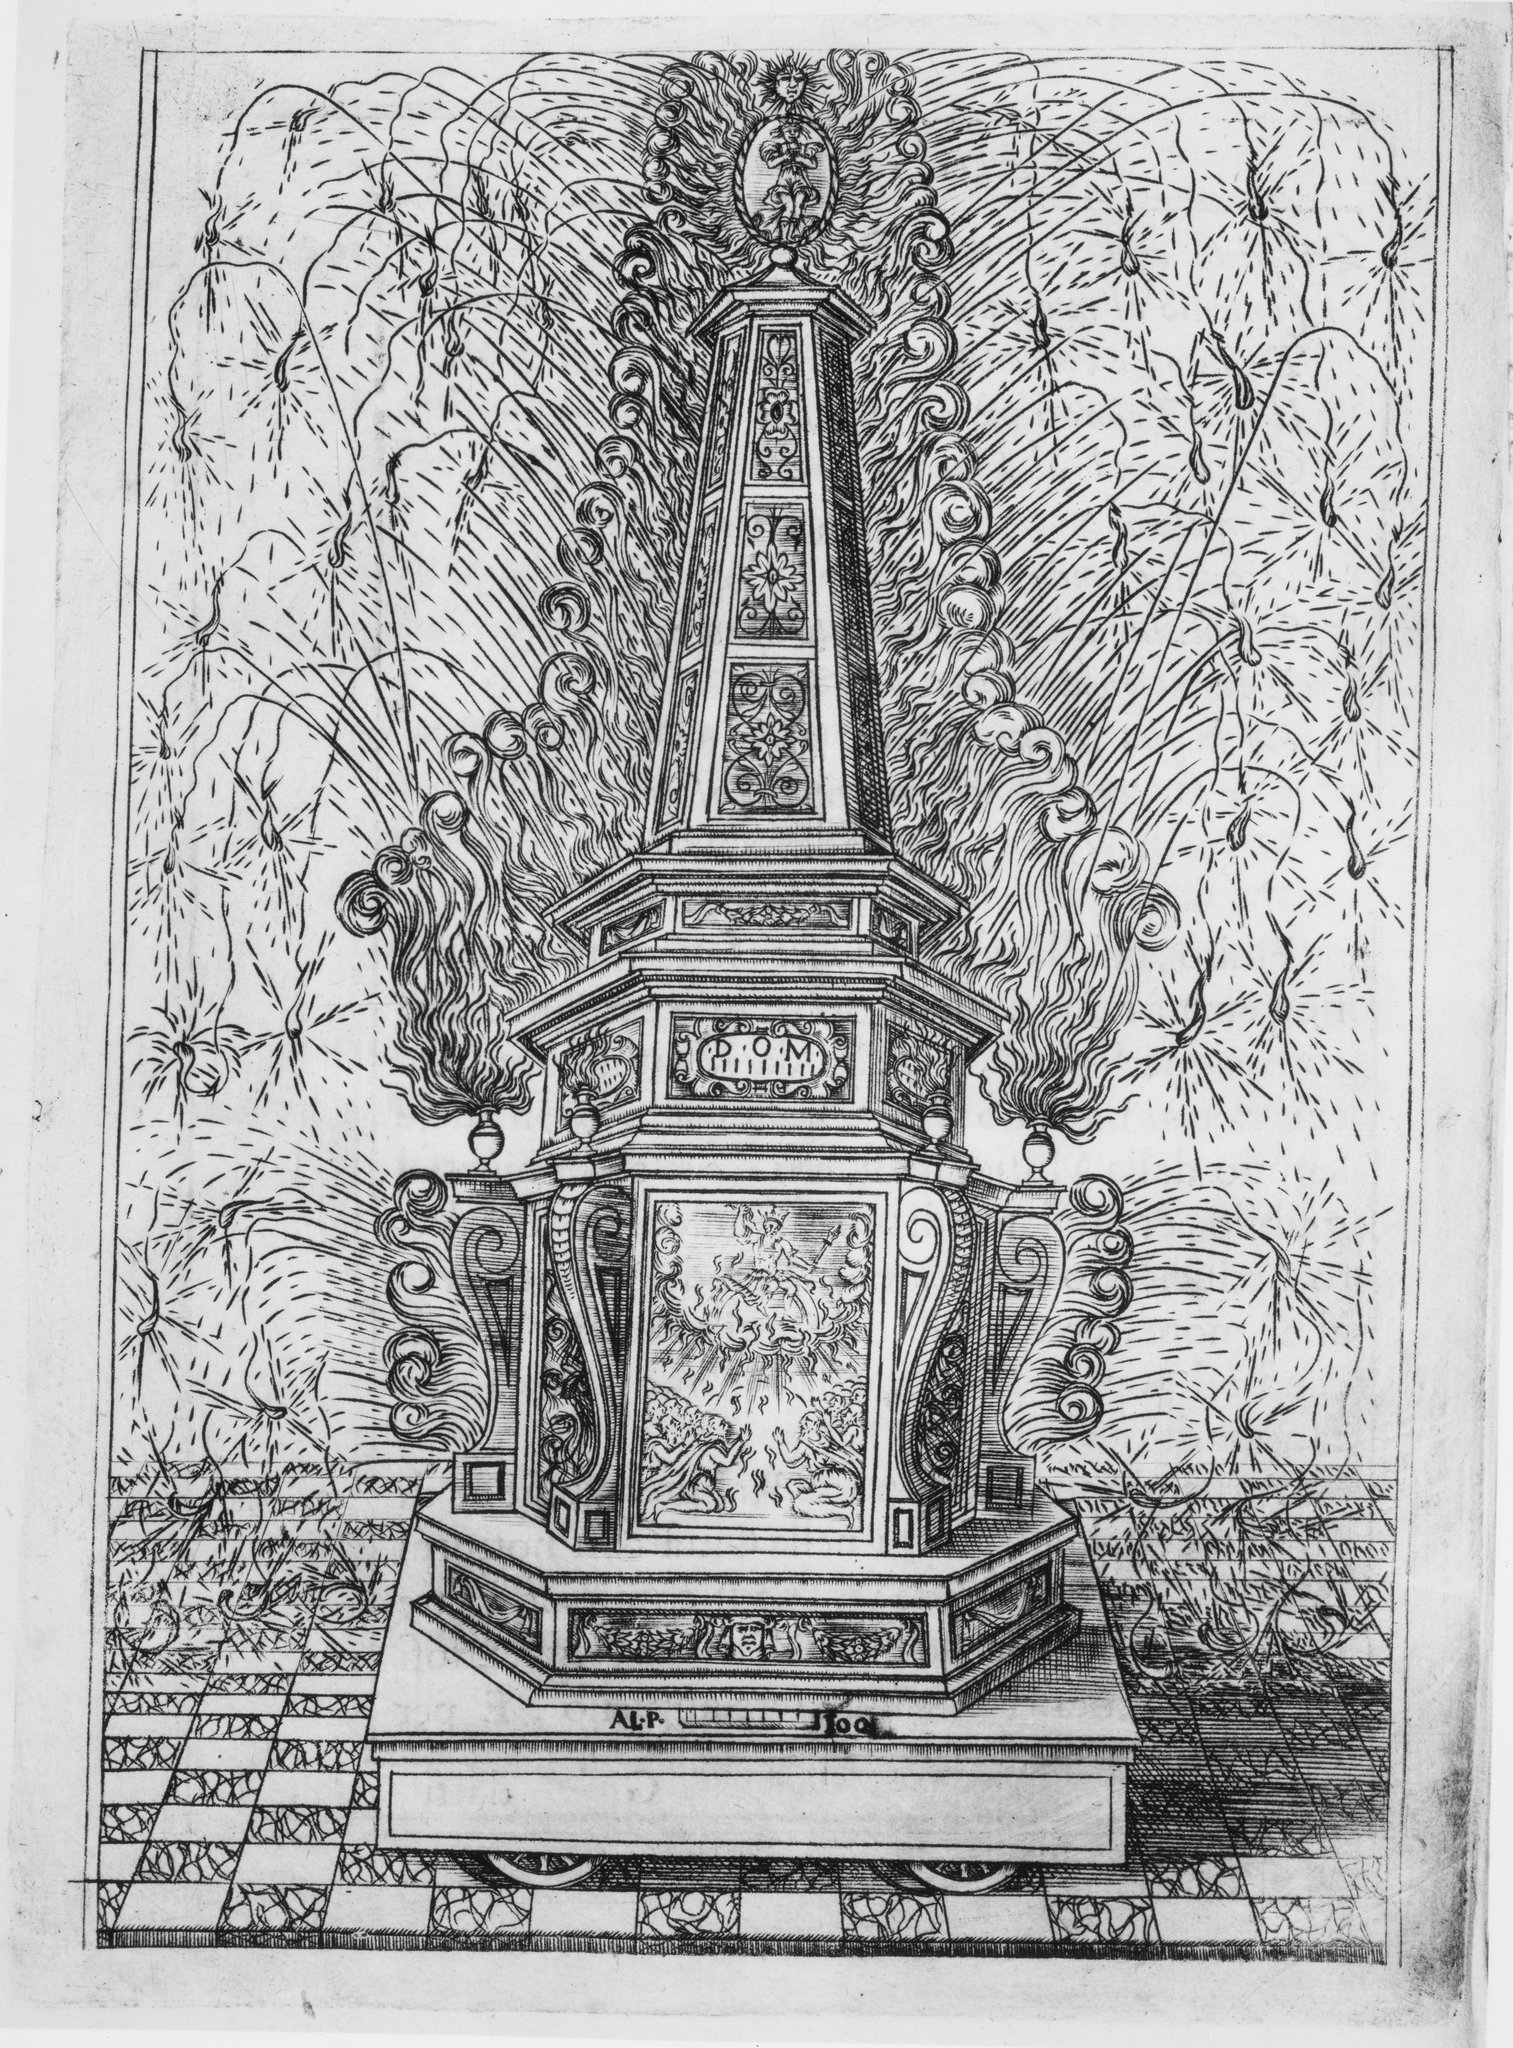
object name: print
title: Festival for Saint Placidus, Messina, August 2, 1589: Fireworks Obelisk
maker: filippo gotho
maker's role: author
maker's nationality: italian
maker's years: 1500-1600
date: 1591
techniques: etching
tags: obelisks,fireworks